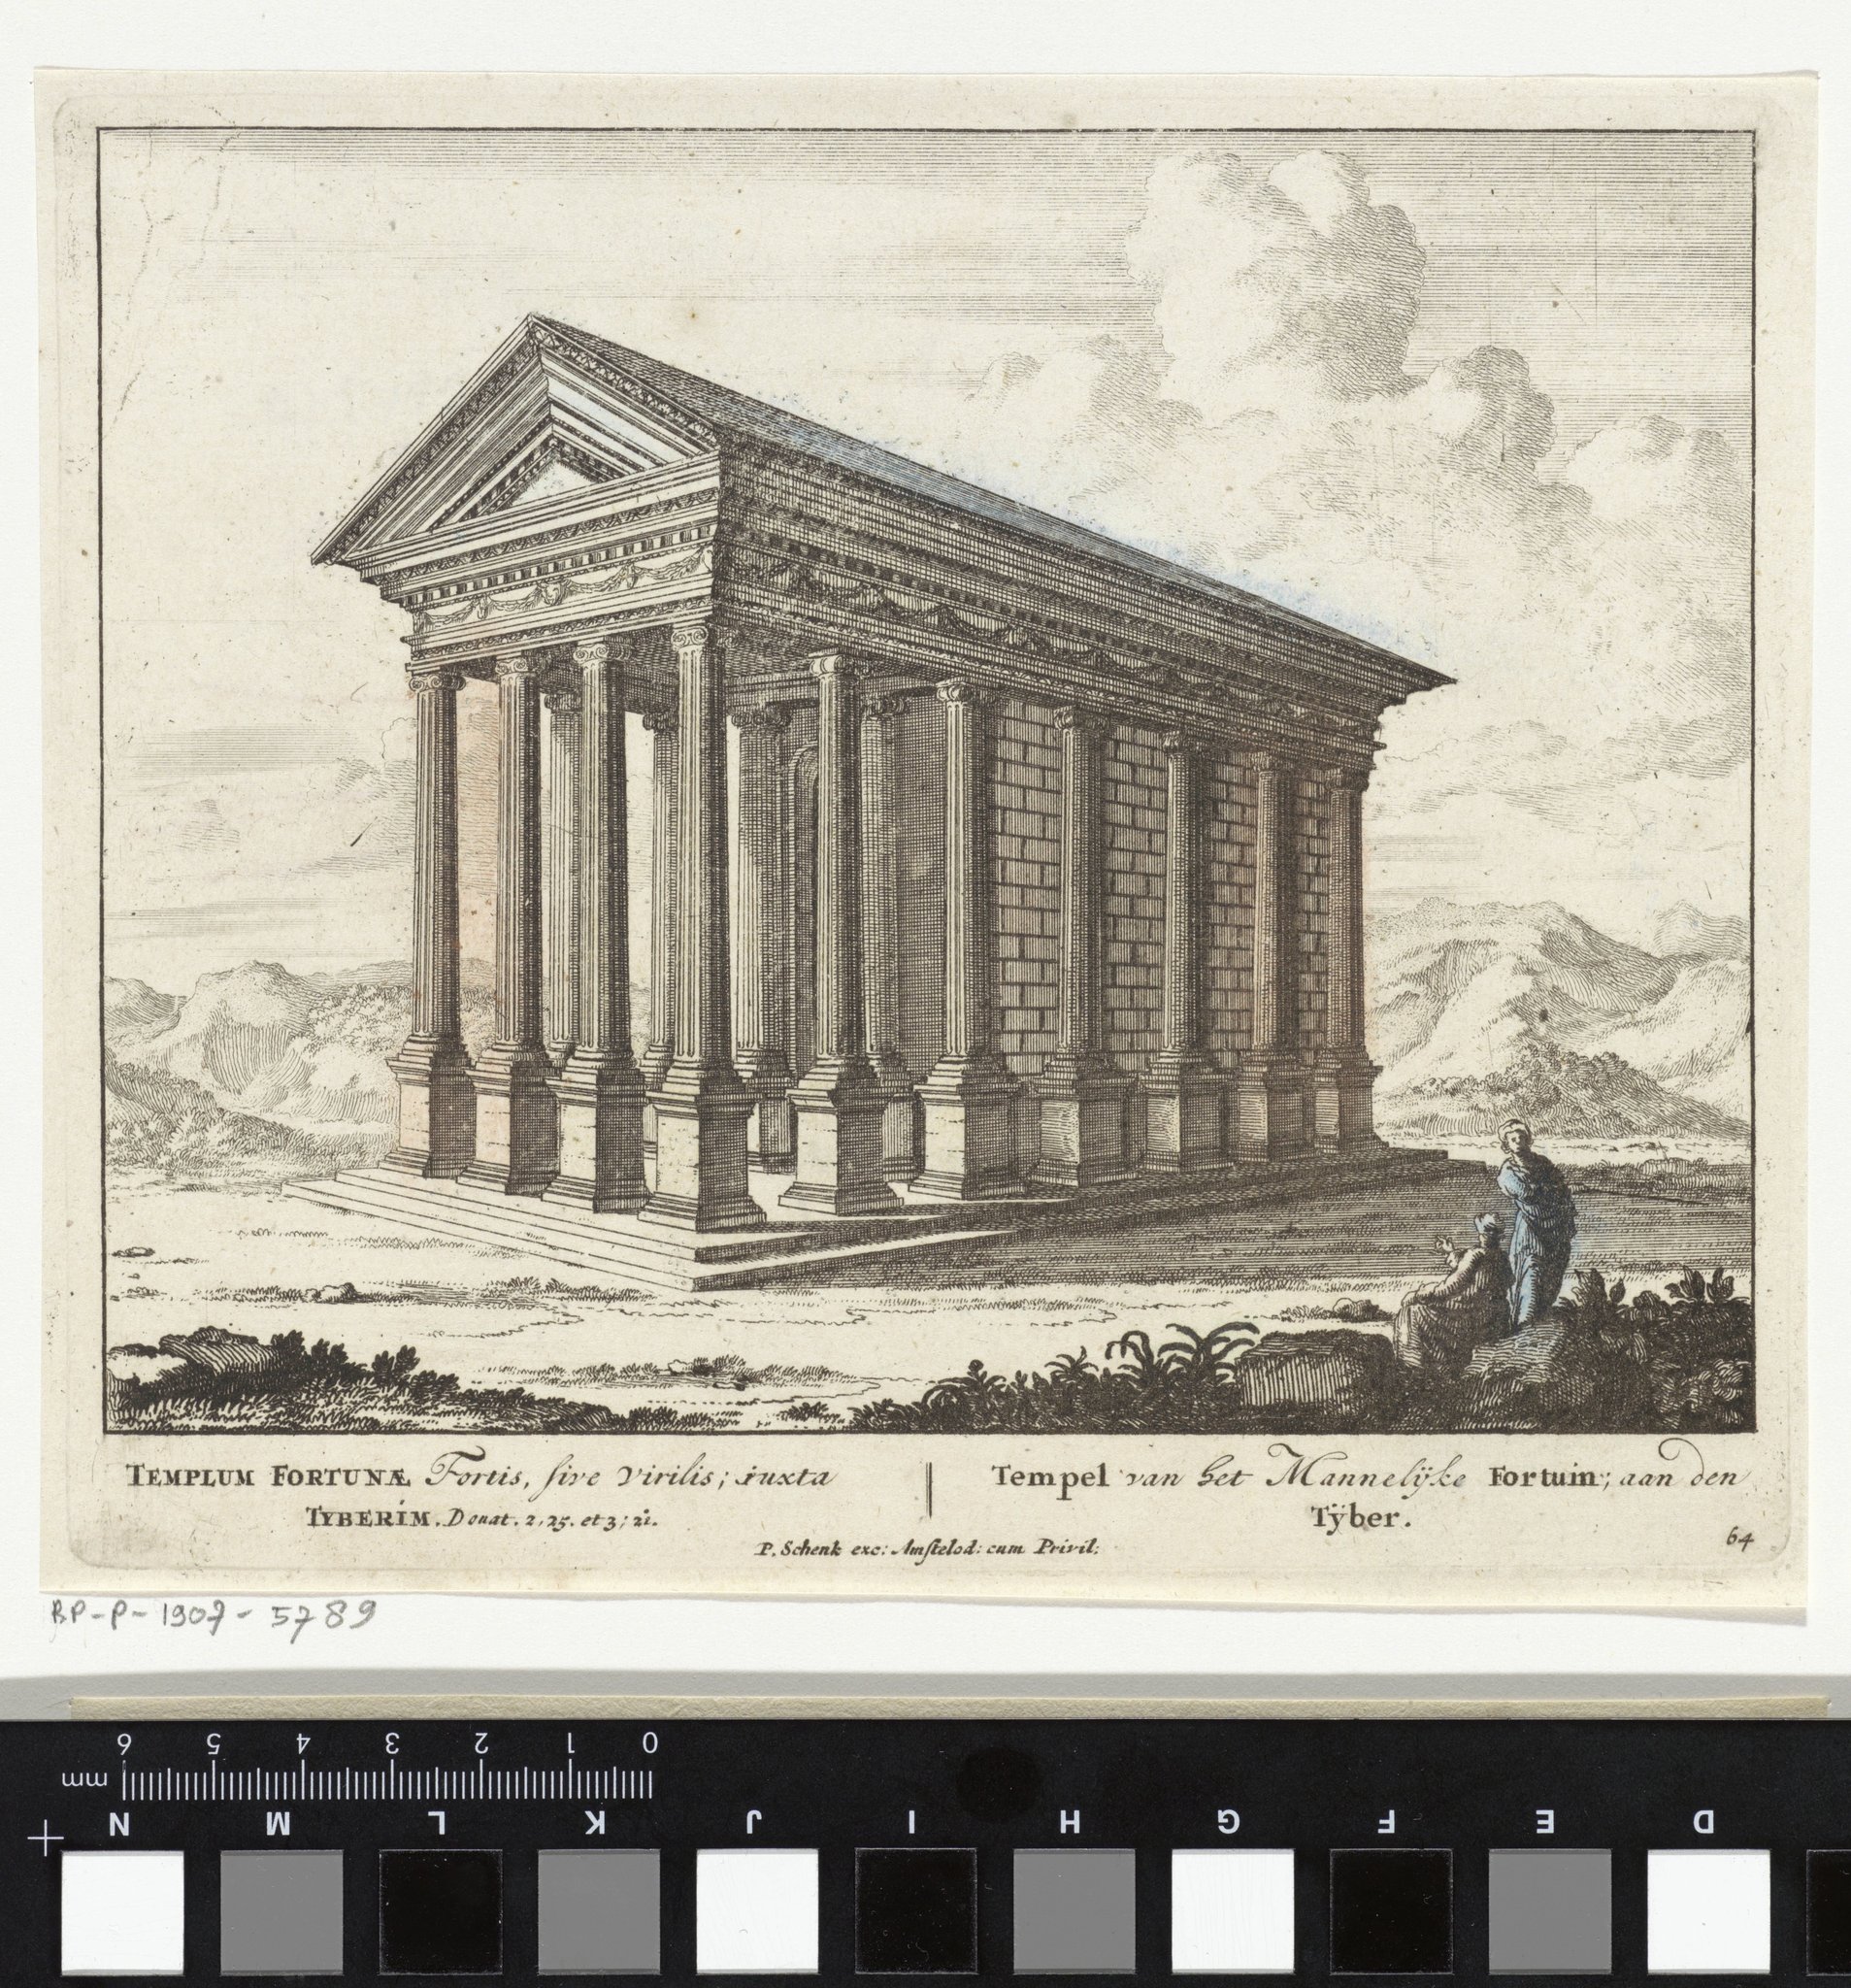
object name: print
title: Tempel van het Mannelijke Fortuin, aan den Tyber.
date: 1675-1711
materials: paper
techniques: etching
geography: amsterdam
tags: low hill country, temple, shrine ~ roman religion, rome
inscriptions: collector's mark: Lugt 2228